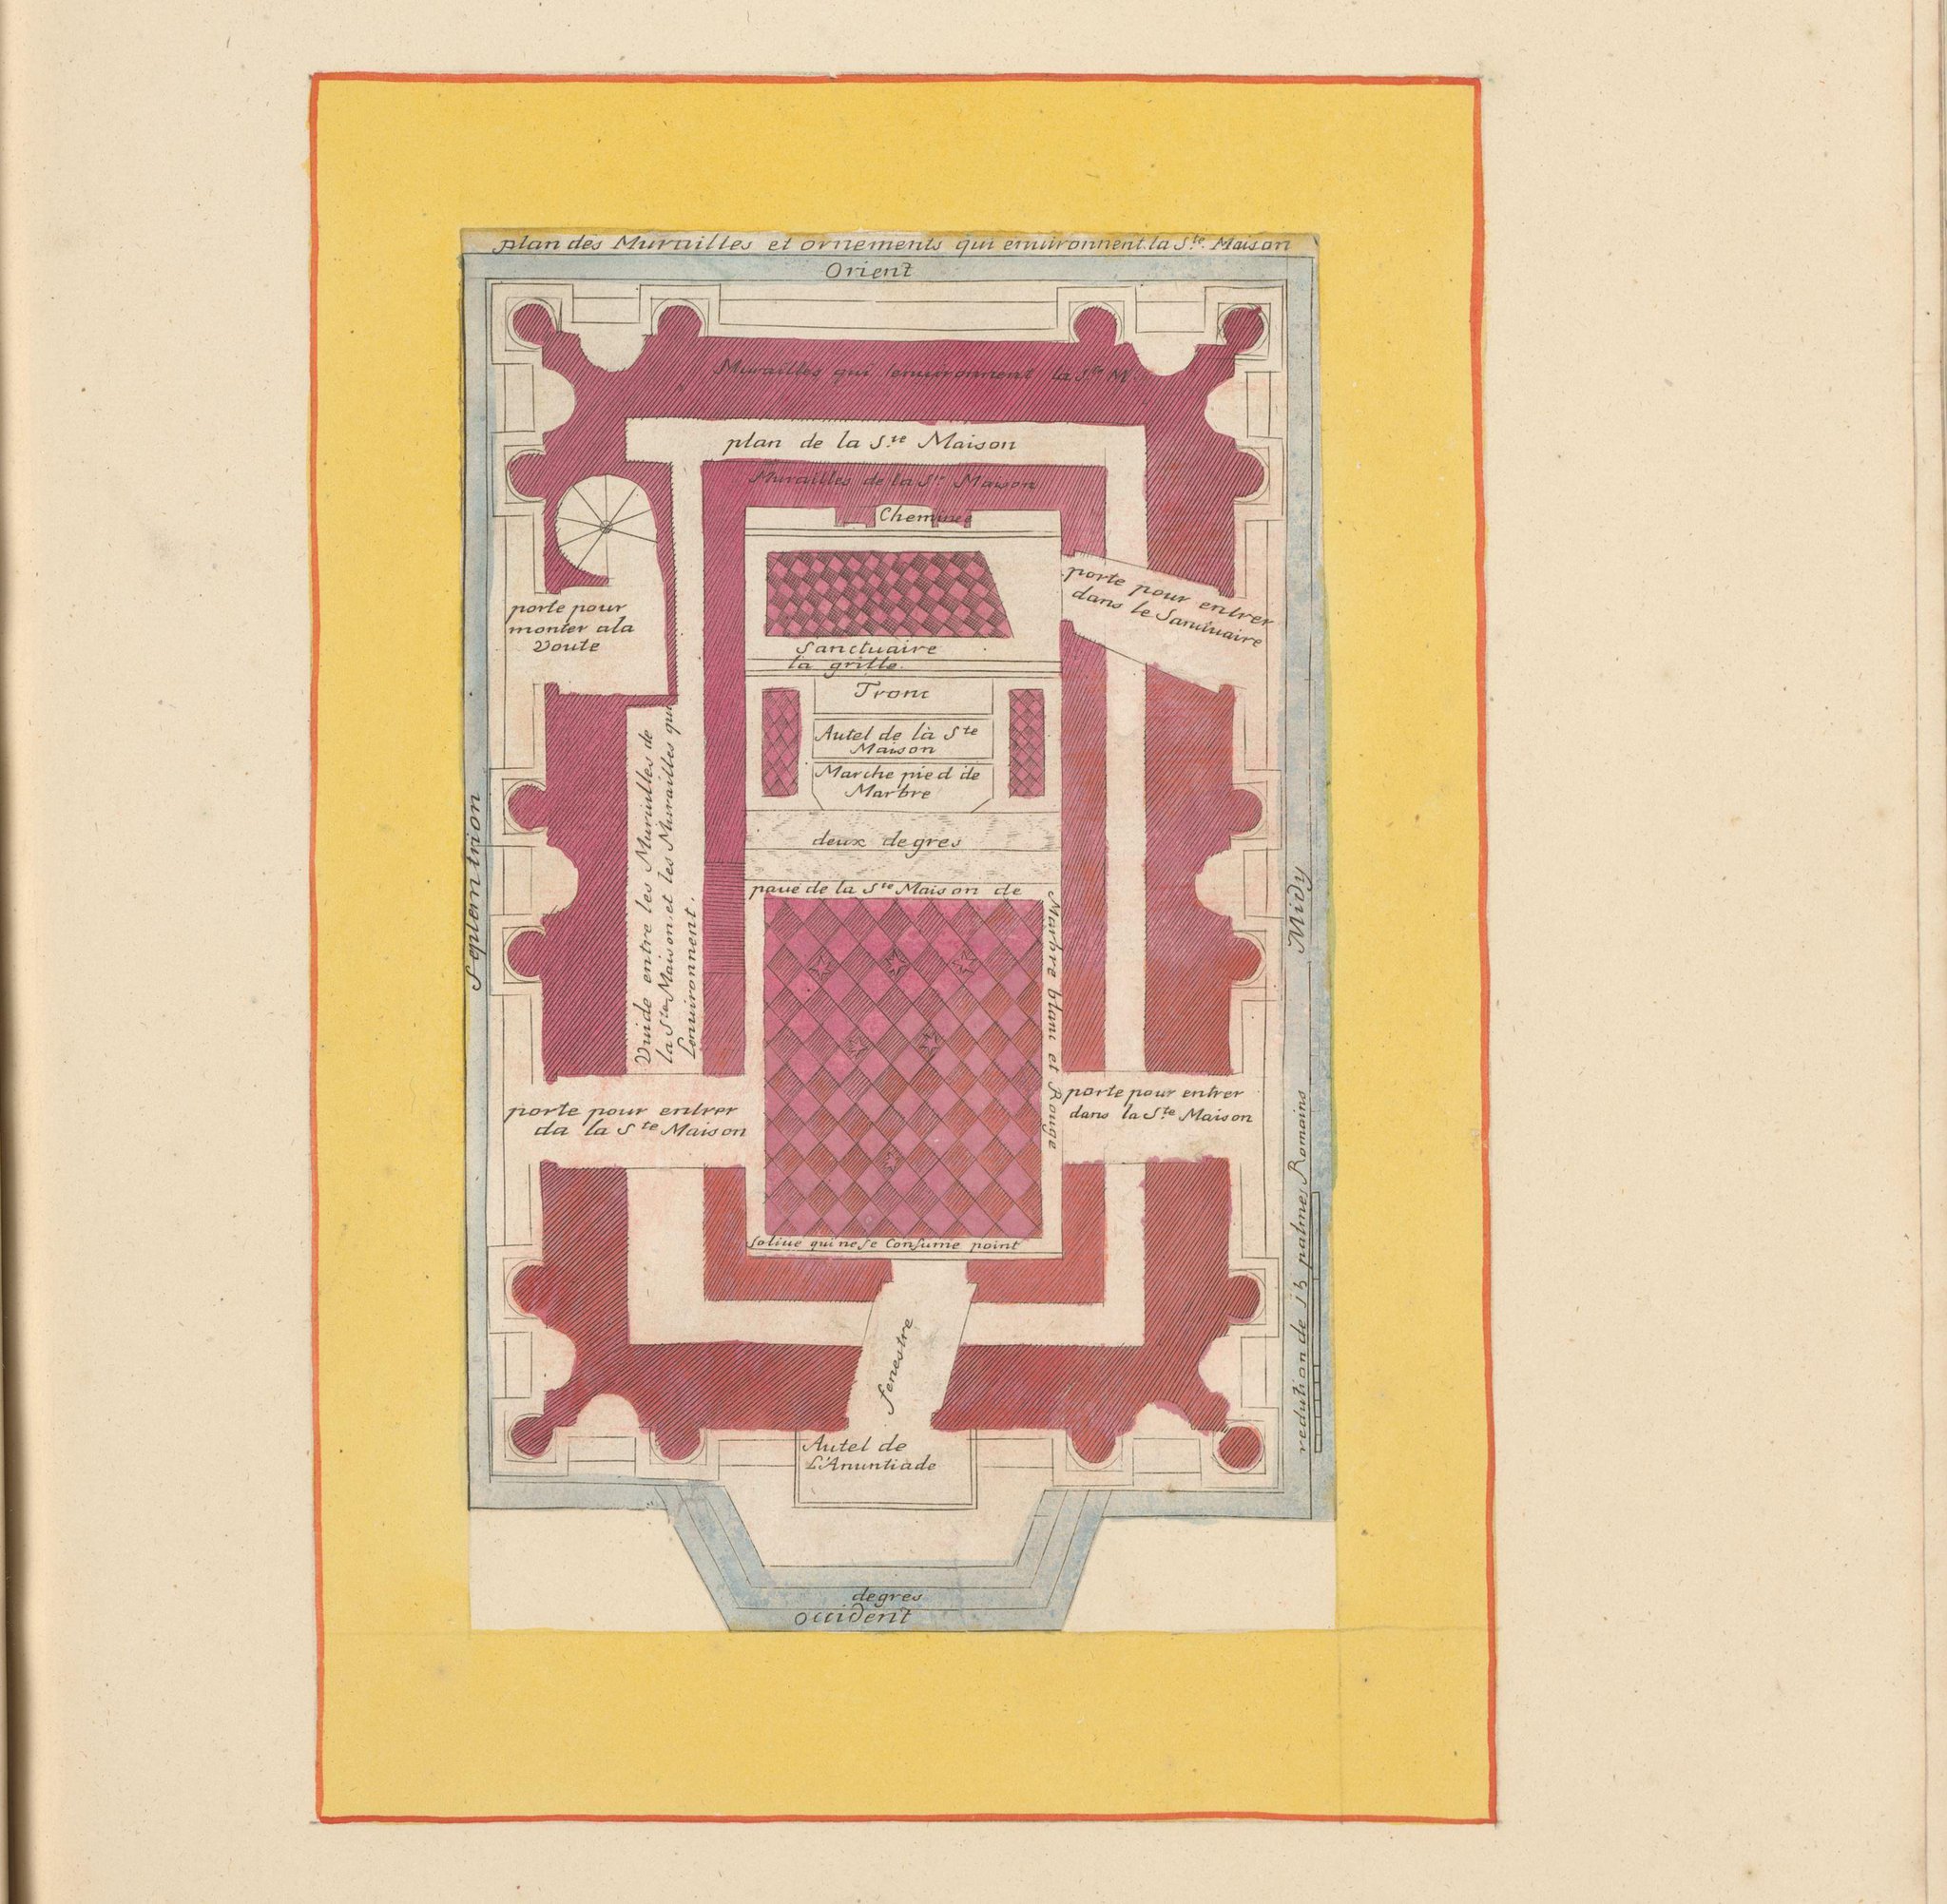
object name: print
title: Plan des Murnilles et ornements qui environnent la S.te Maison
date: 1693-1717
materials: paper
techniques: colour, engraving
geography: the hague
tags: plan ~ architecture